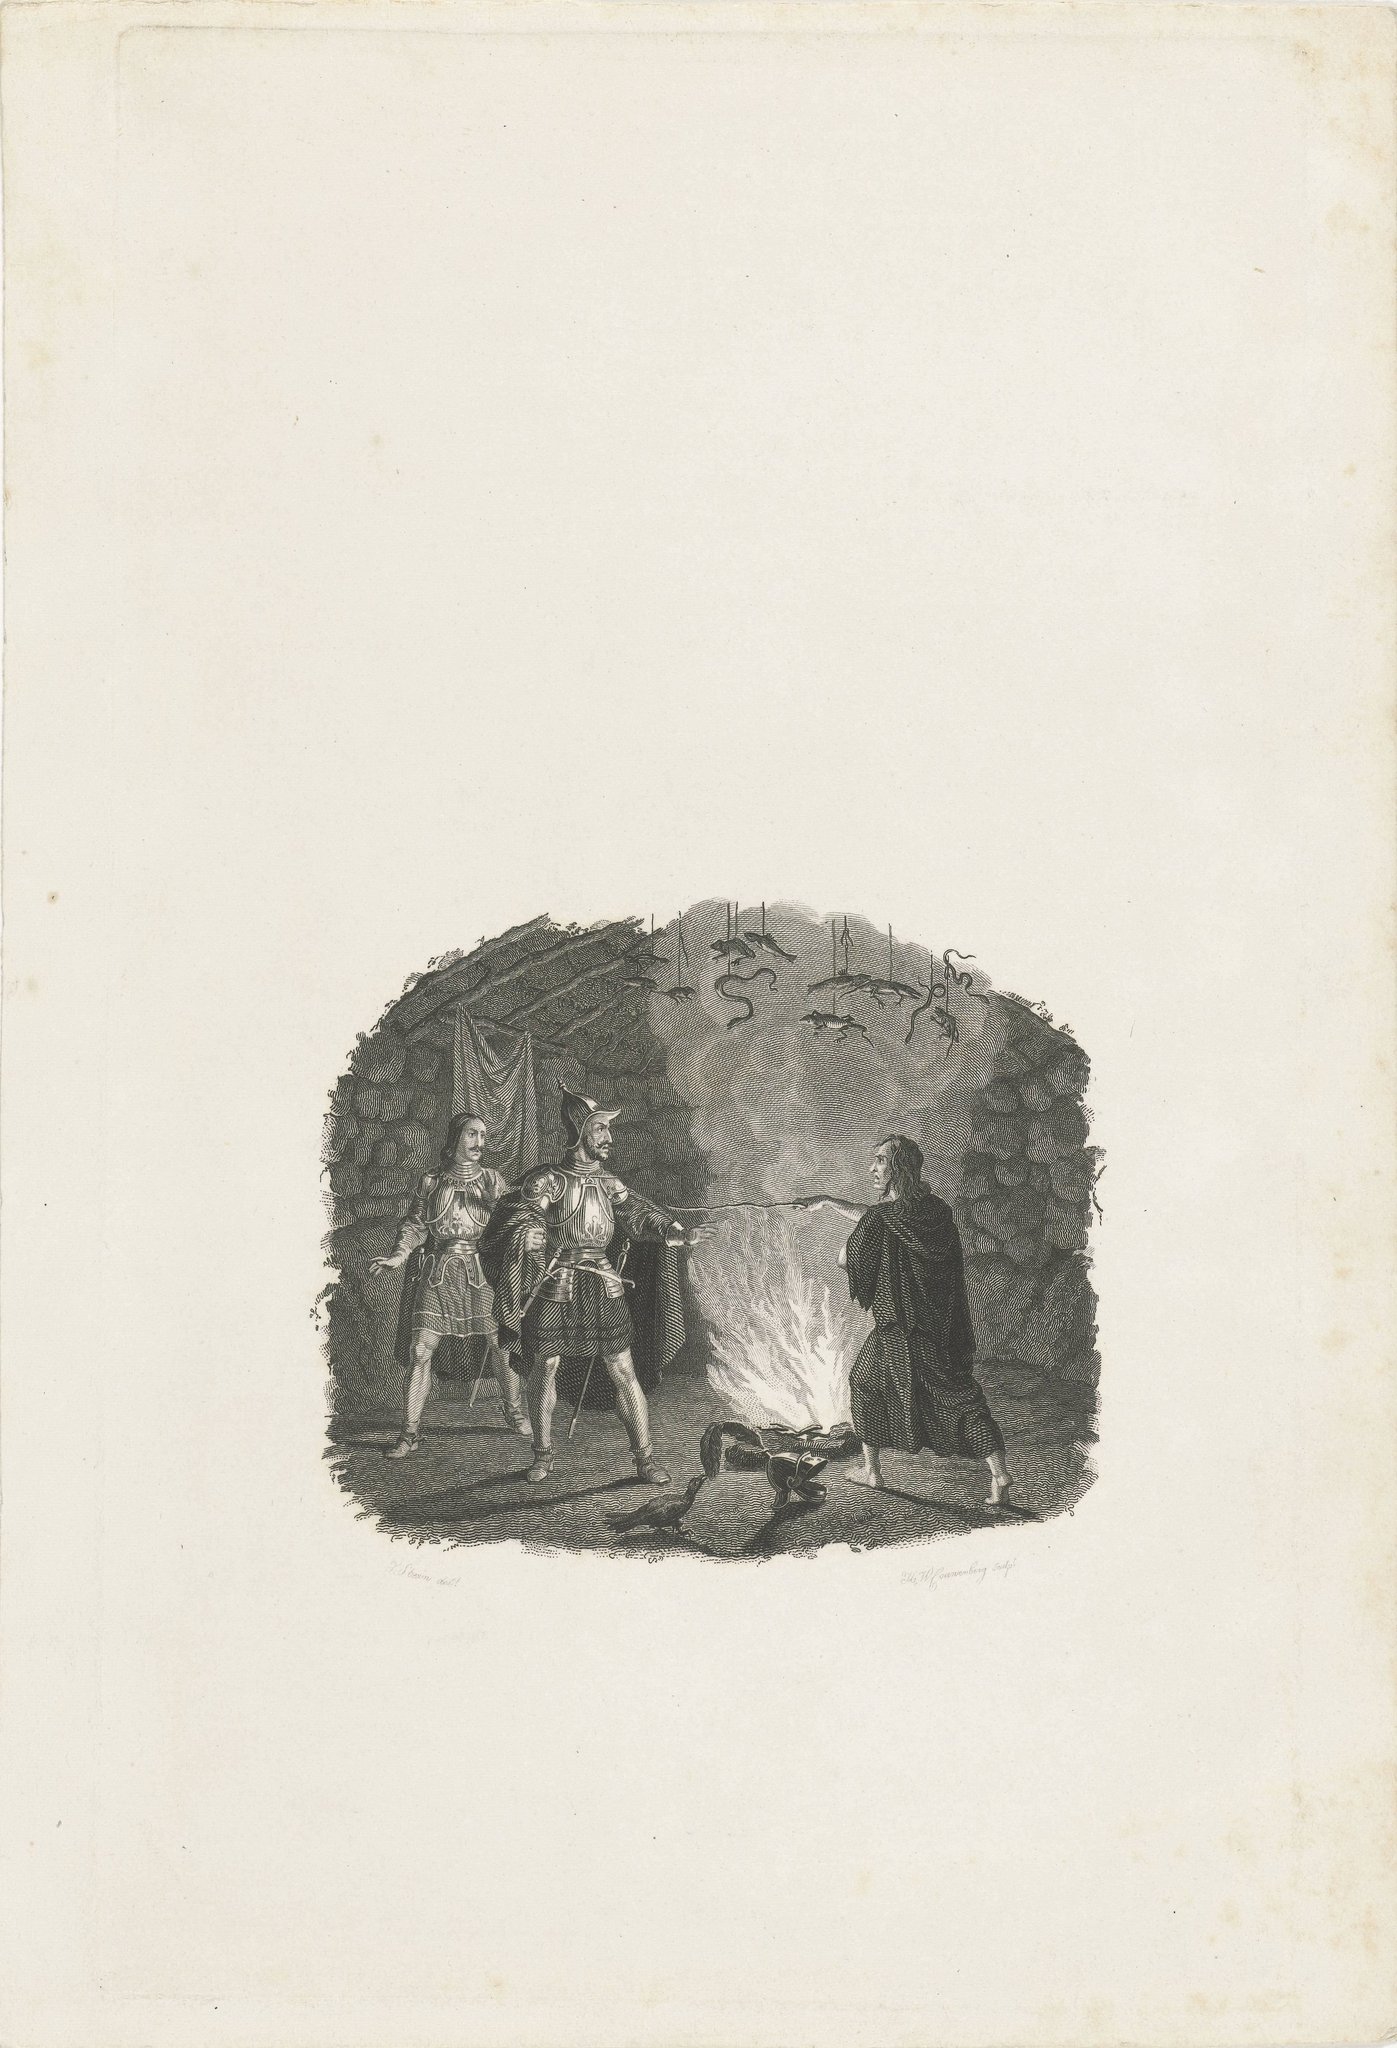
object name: book illustration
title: Twee soldaten in de hut van een alchemist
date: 1830-1845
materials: paper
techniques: engraving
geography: amsterdam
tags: alchemist at work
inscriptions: collector's mark: Lugt 2228